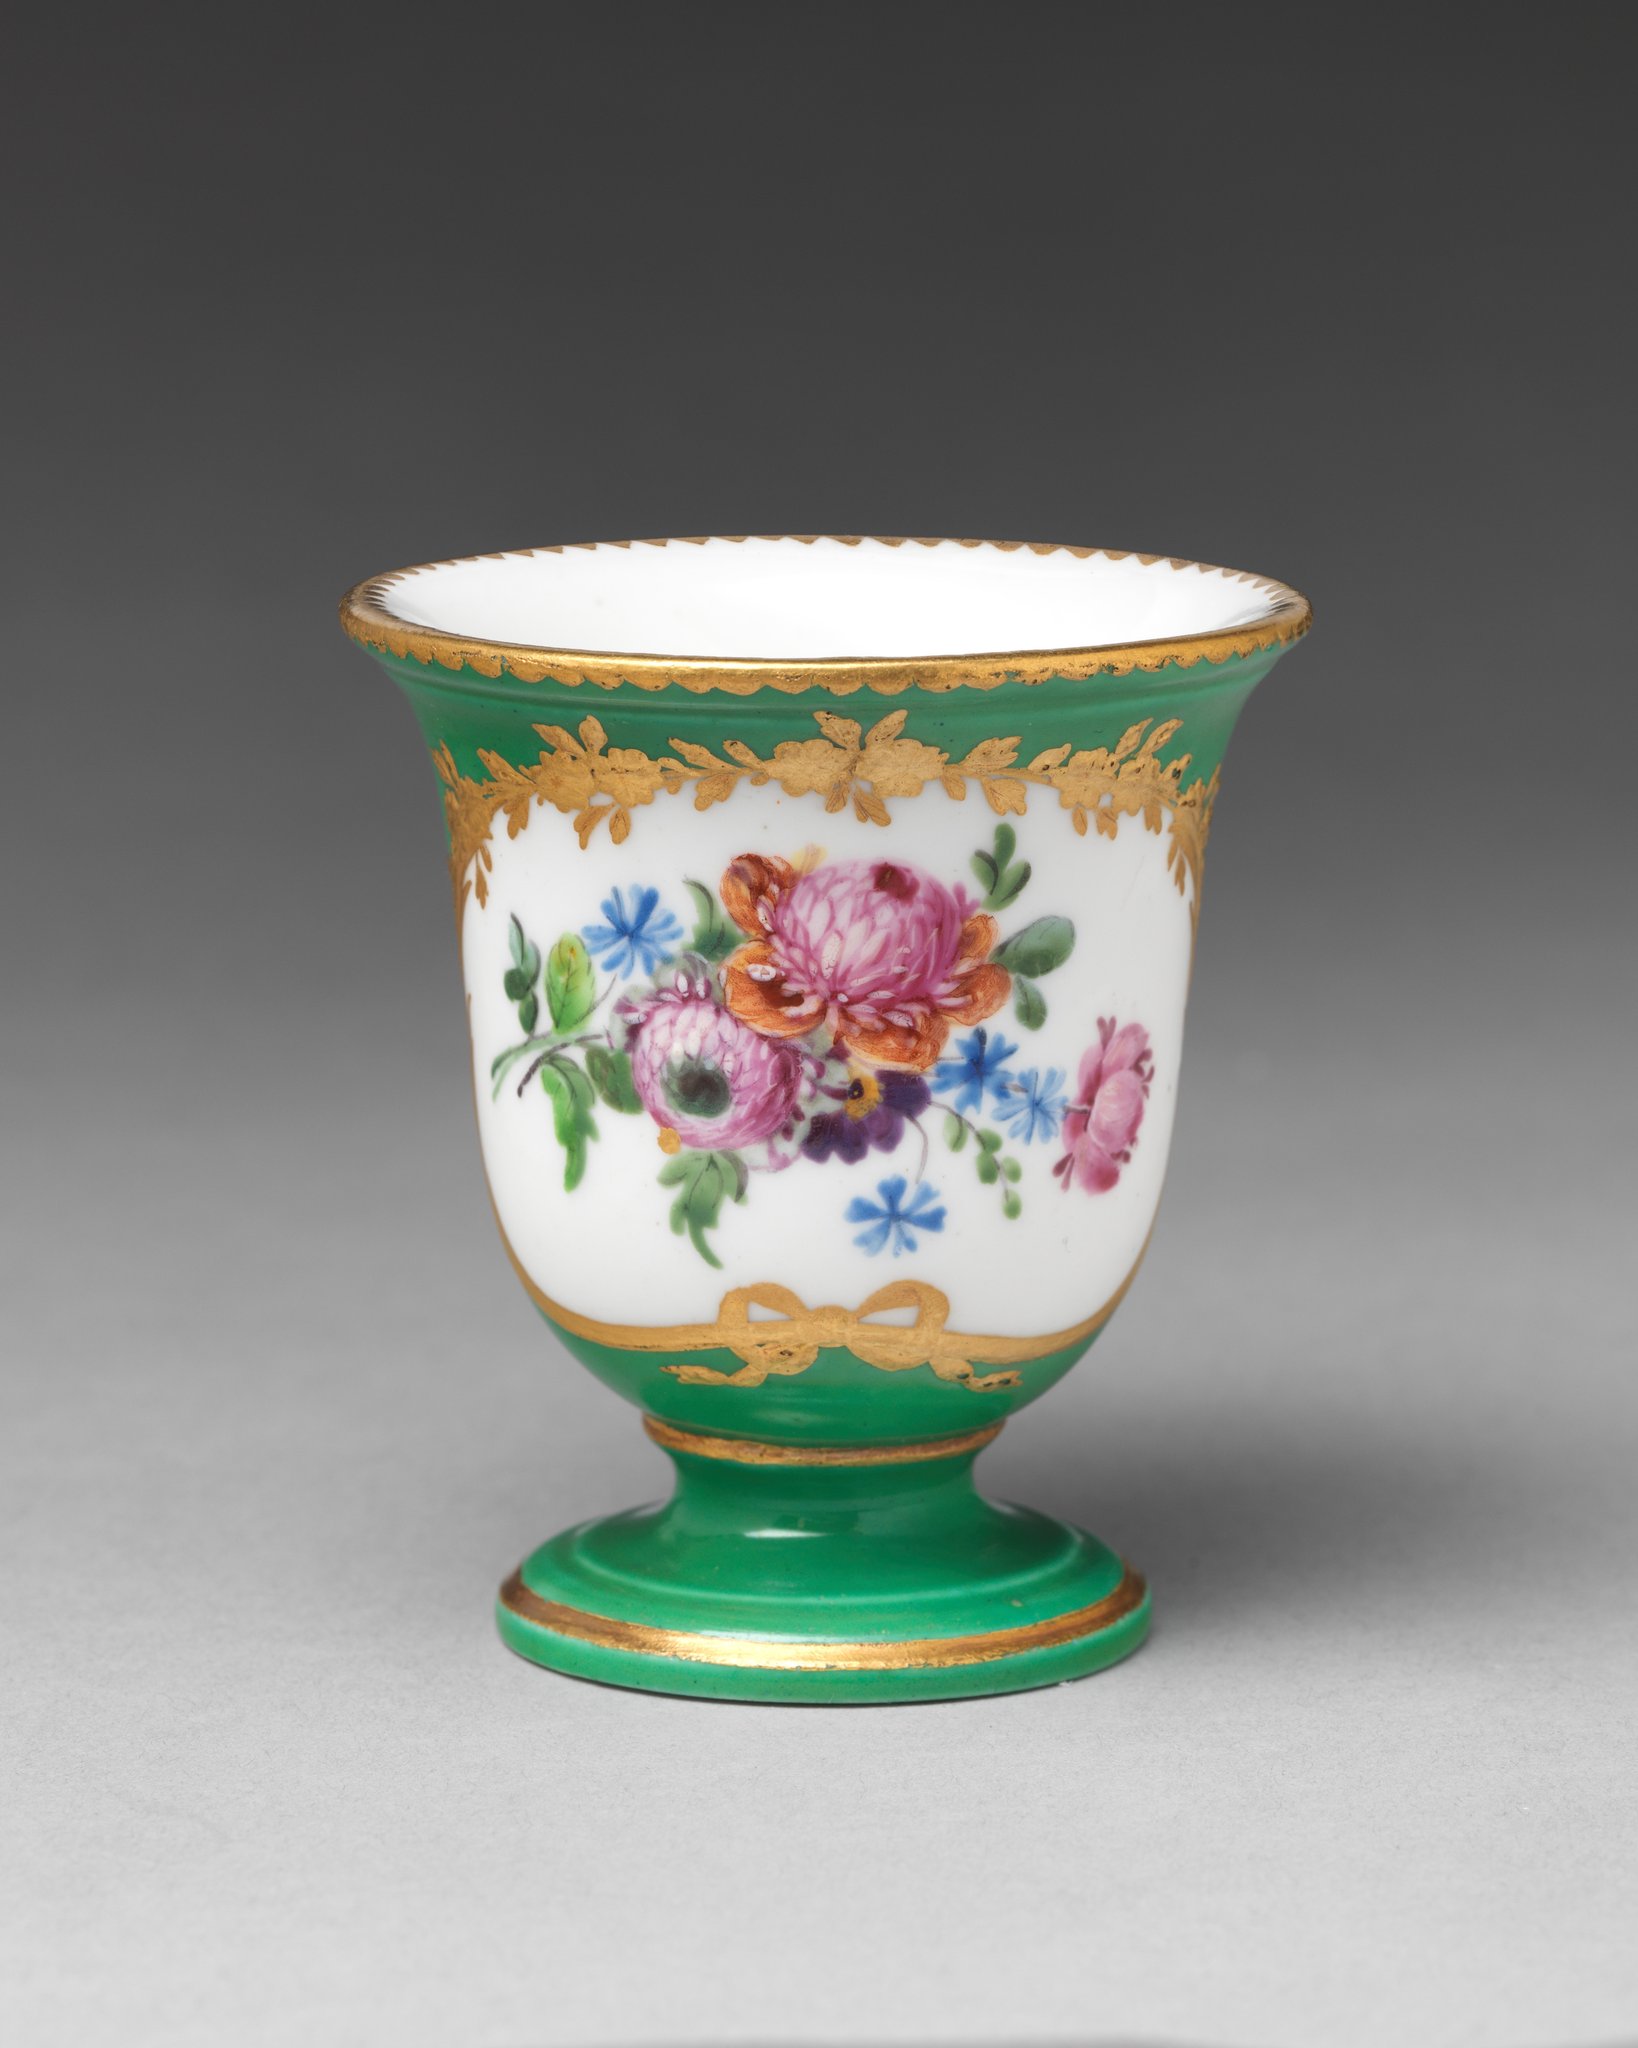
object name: ice cream cup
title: Ice cream cup (Tasse à glace) (part of a service)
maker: sèvres manufactory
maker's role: manufactory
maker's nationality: french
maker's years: 1740-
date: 1771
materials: soft paste porcelain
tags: flowers